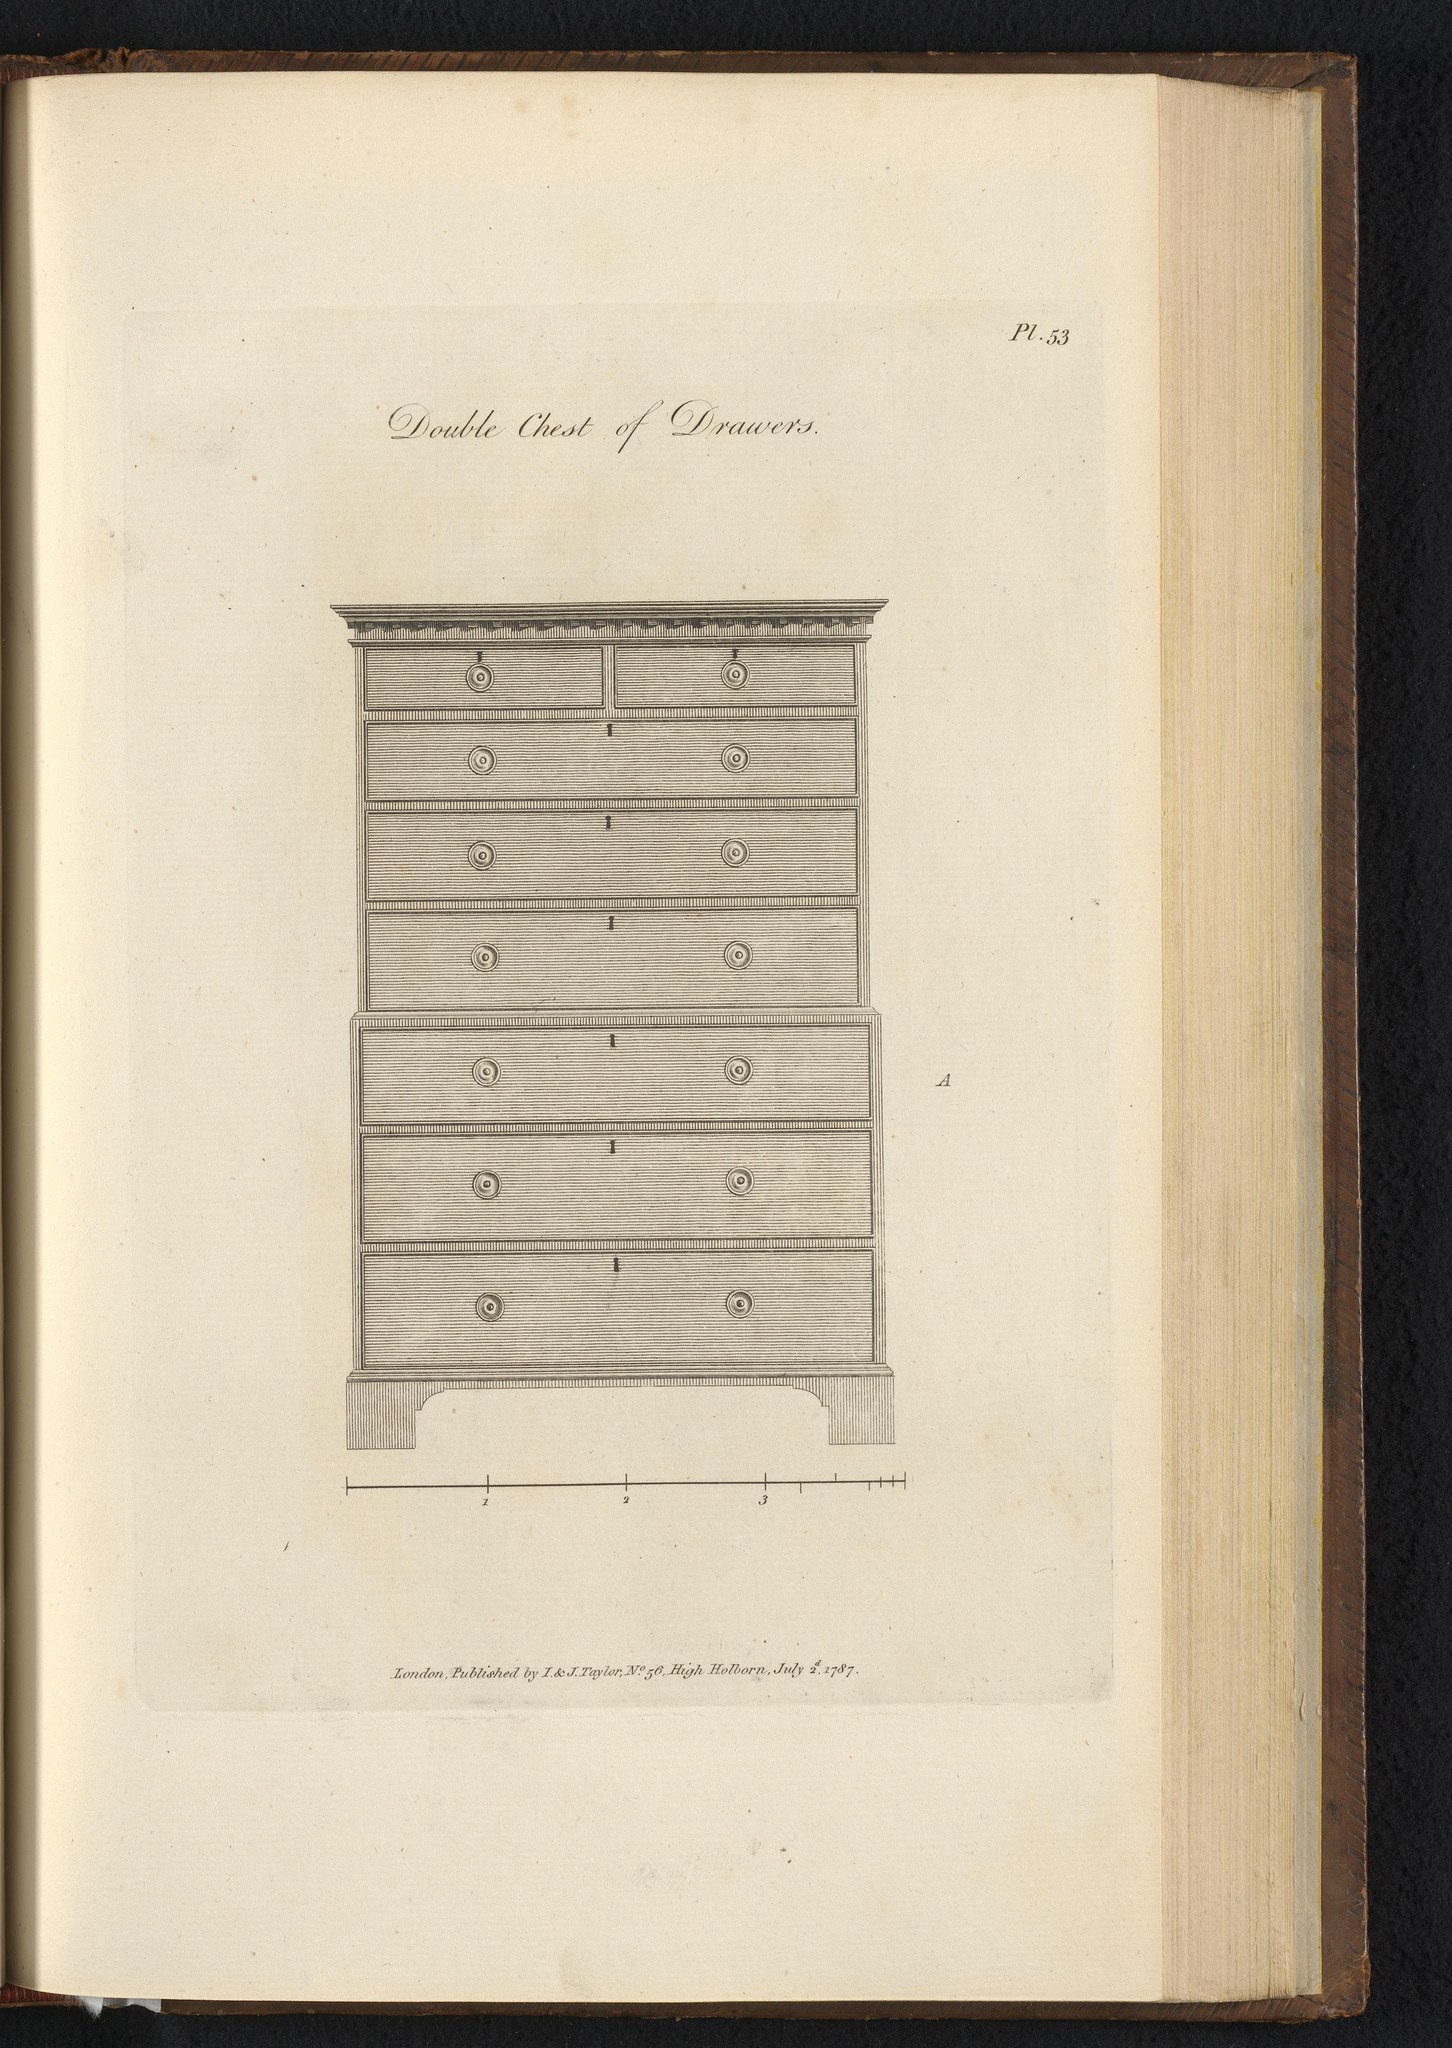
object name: print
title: Meubels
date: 1787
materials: paper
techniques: engraving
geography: holborn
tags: wardrobe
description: Genummerd: Pl. 53. Kast gemerkt als: A. Schaalverdeling in de ondermarge. Prent maakt deel uit van een boek.